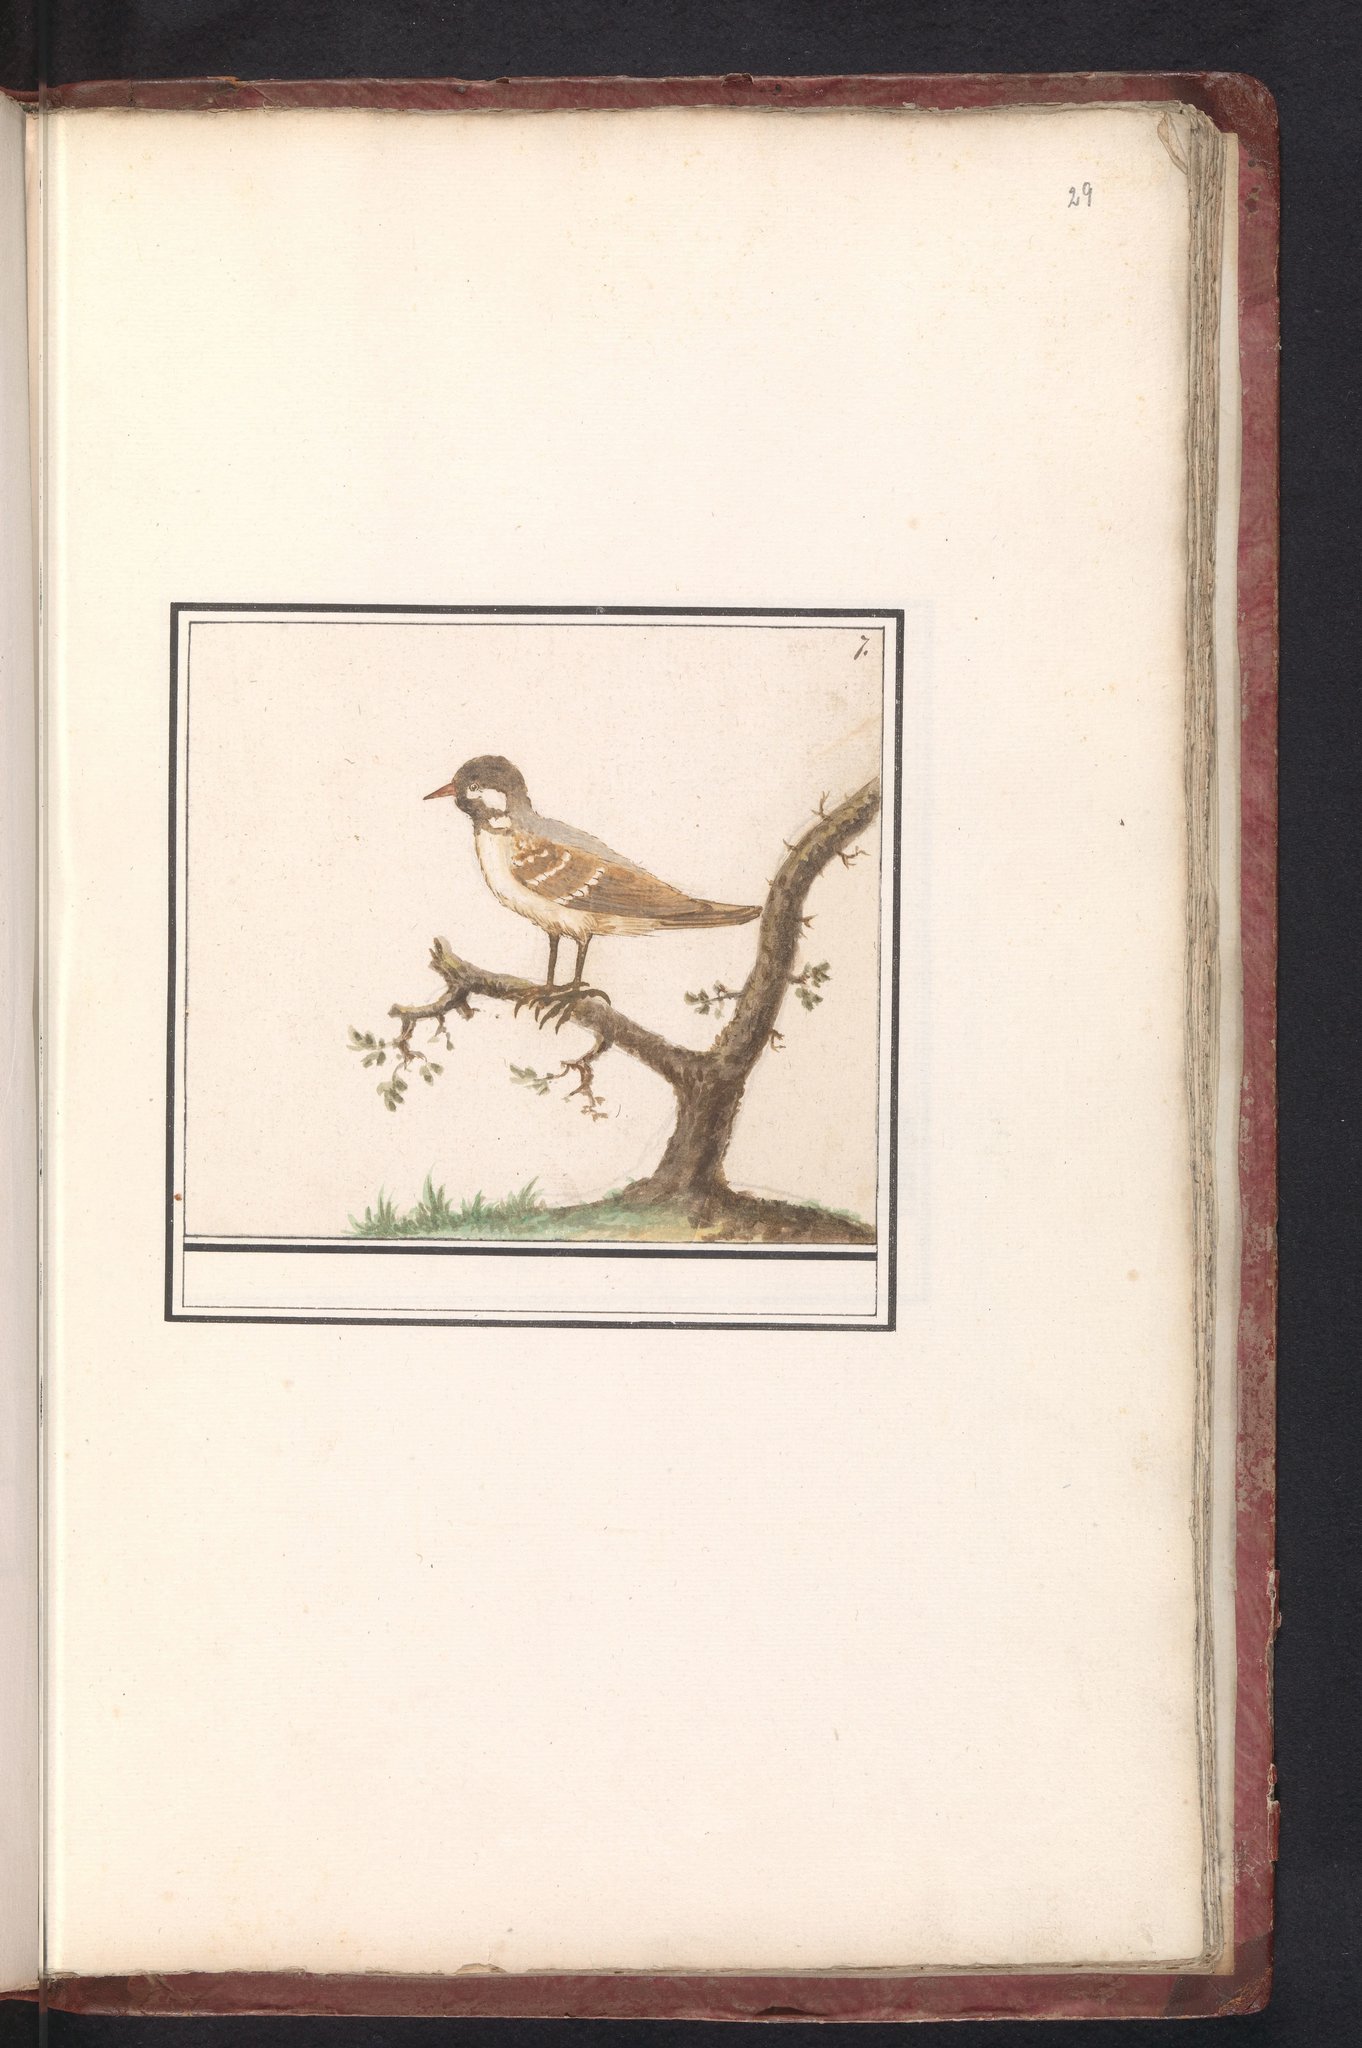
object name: drawing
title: Vogel (onbekend)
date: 1596-1610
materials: paint, paper, pencil, watercolor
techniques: brush, pen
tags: song-birds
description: Vogel (onbekende soort), mogelijk een mees. Genummerd rechtsboven: 7. Onderdeel van het tweede album met tekeningen van vogels. Vierde van twaalf albums met tekeningen van dieren, vogels en planten bekend rond 1600, gemaakt in opdracht van keizer Rudolf II. Met toelichting in Nederlands, Latijn en Frans.